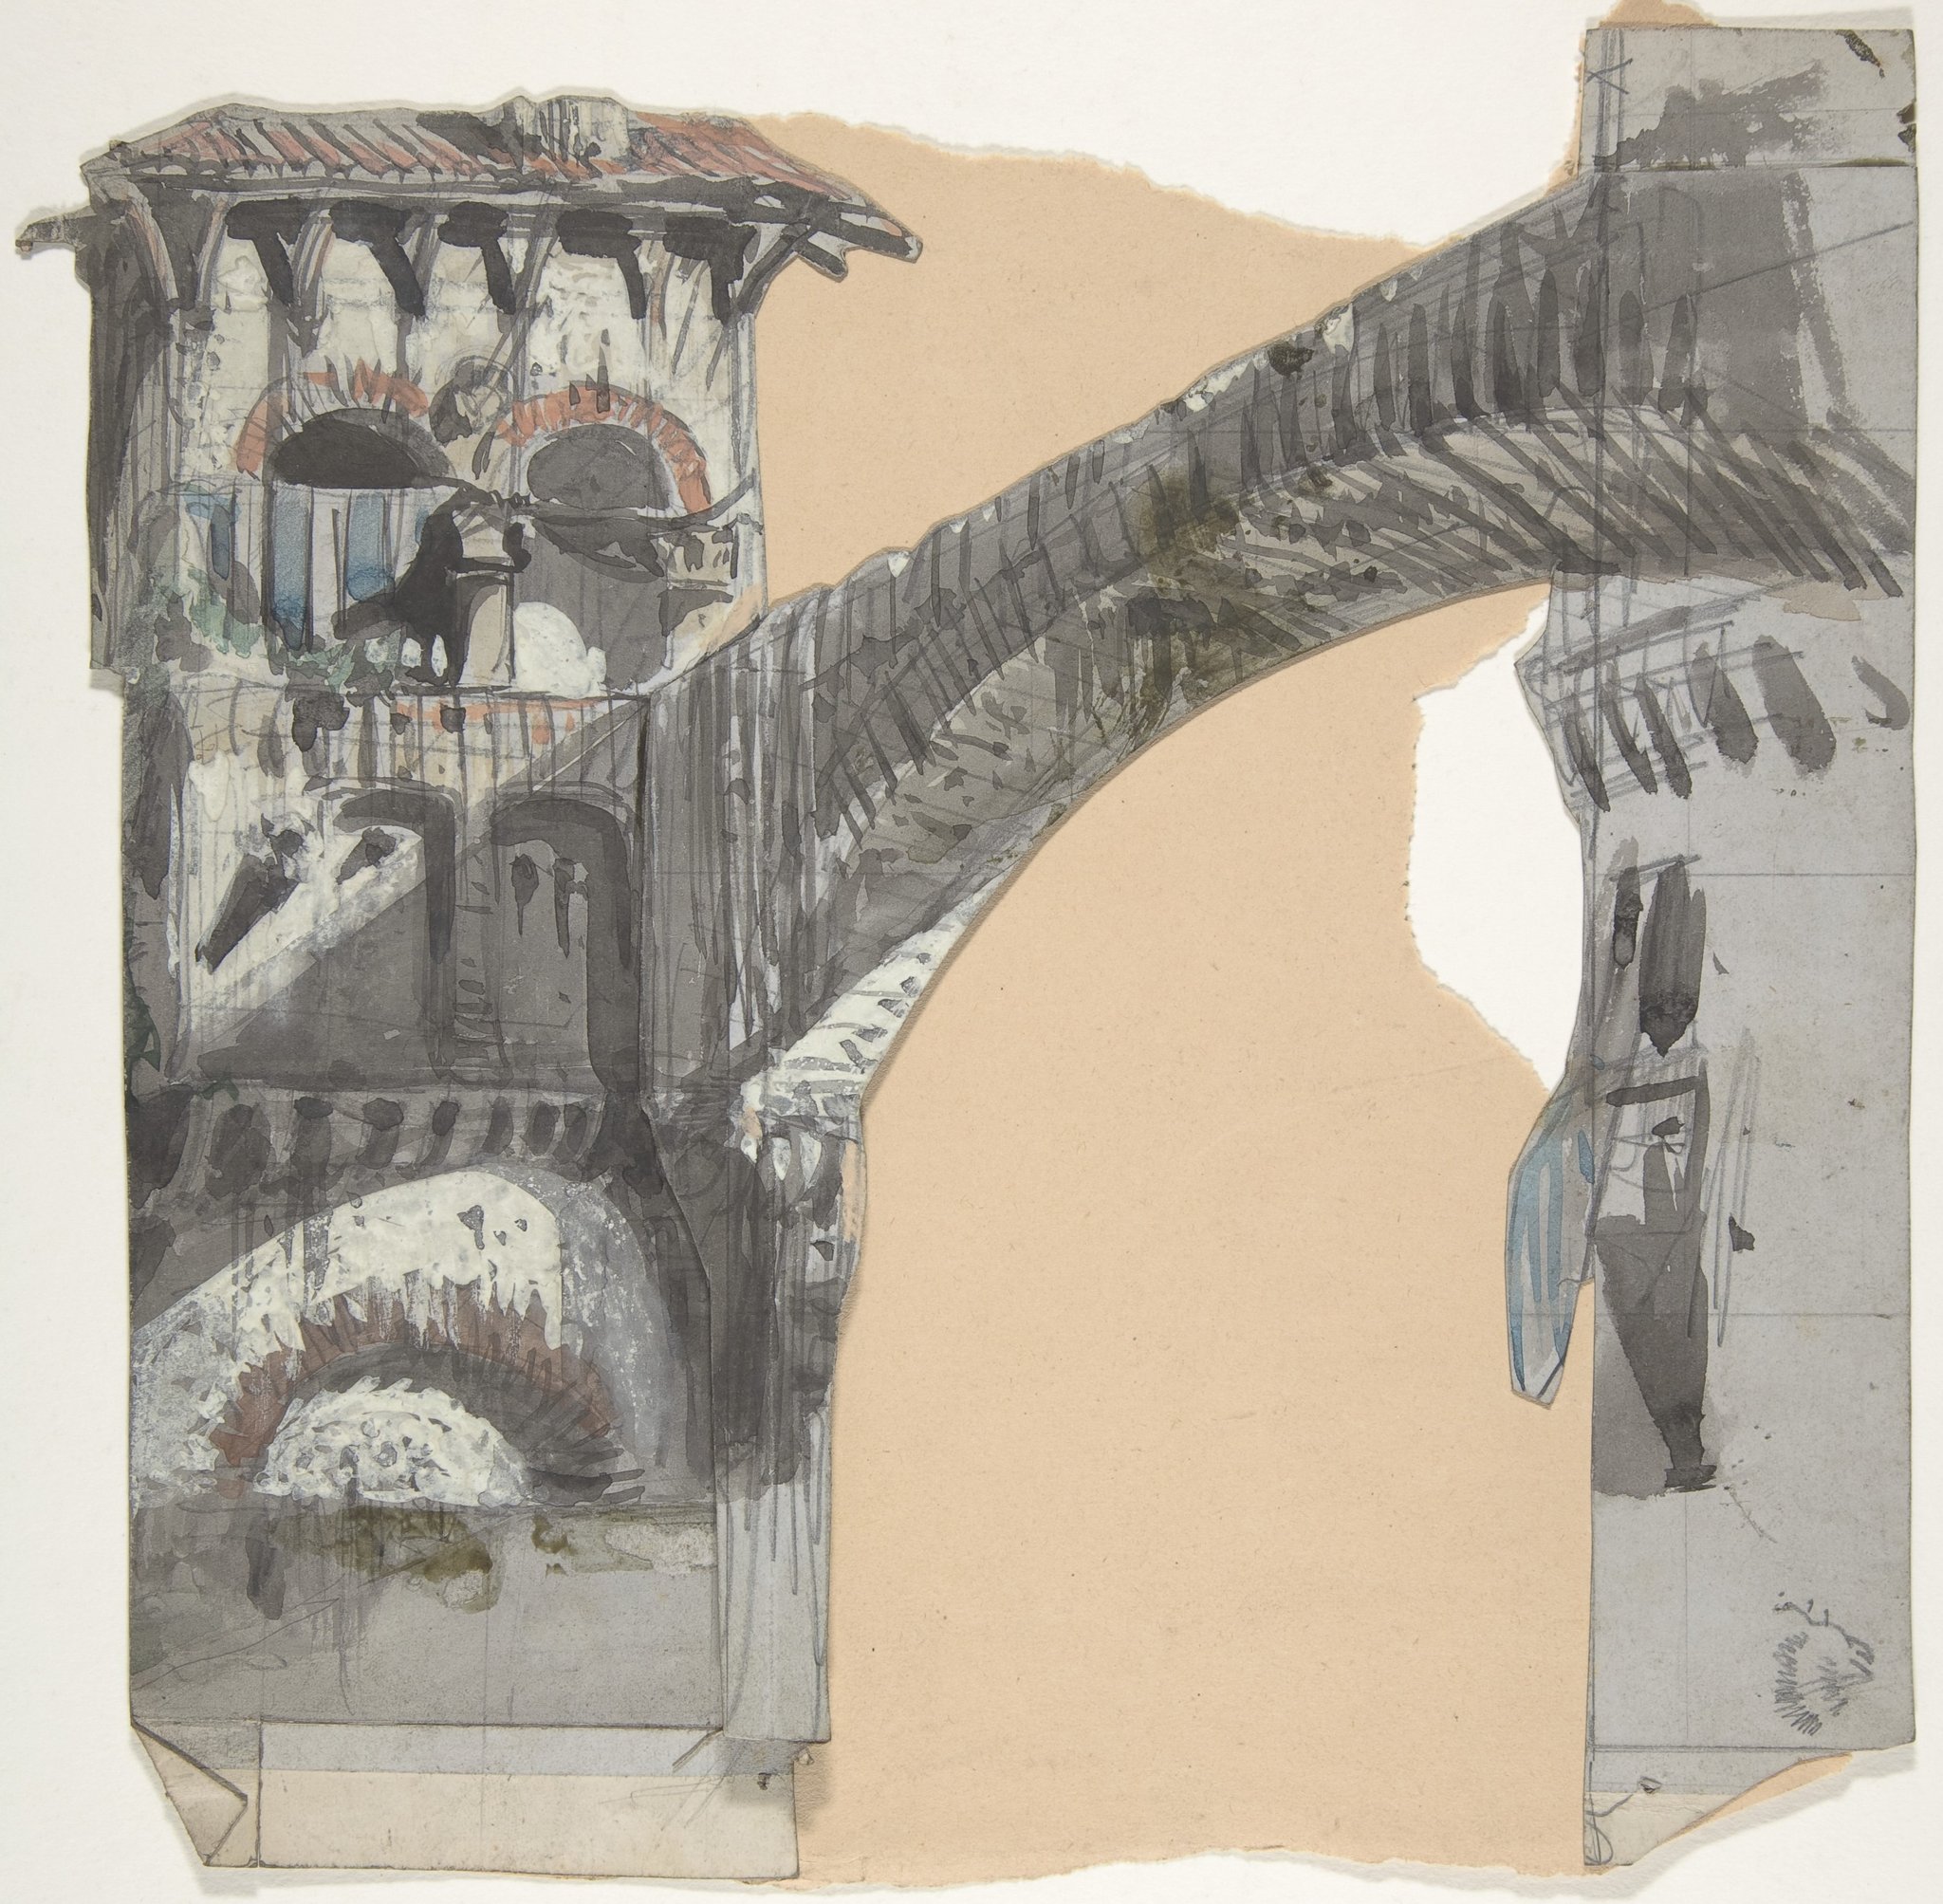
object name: drawing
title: Design for a Stage Set at the Opéra, Paris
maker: eugène cicéri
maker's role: artist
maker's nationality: french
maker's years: 1813-1890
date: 1830-1890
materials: gouache, graphite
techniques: brush, wash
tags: buildings,stage design